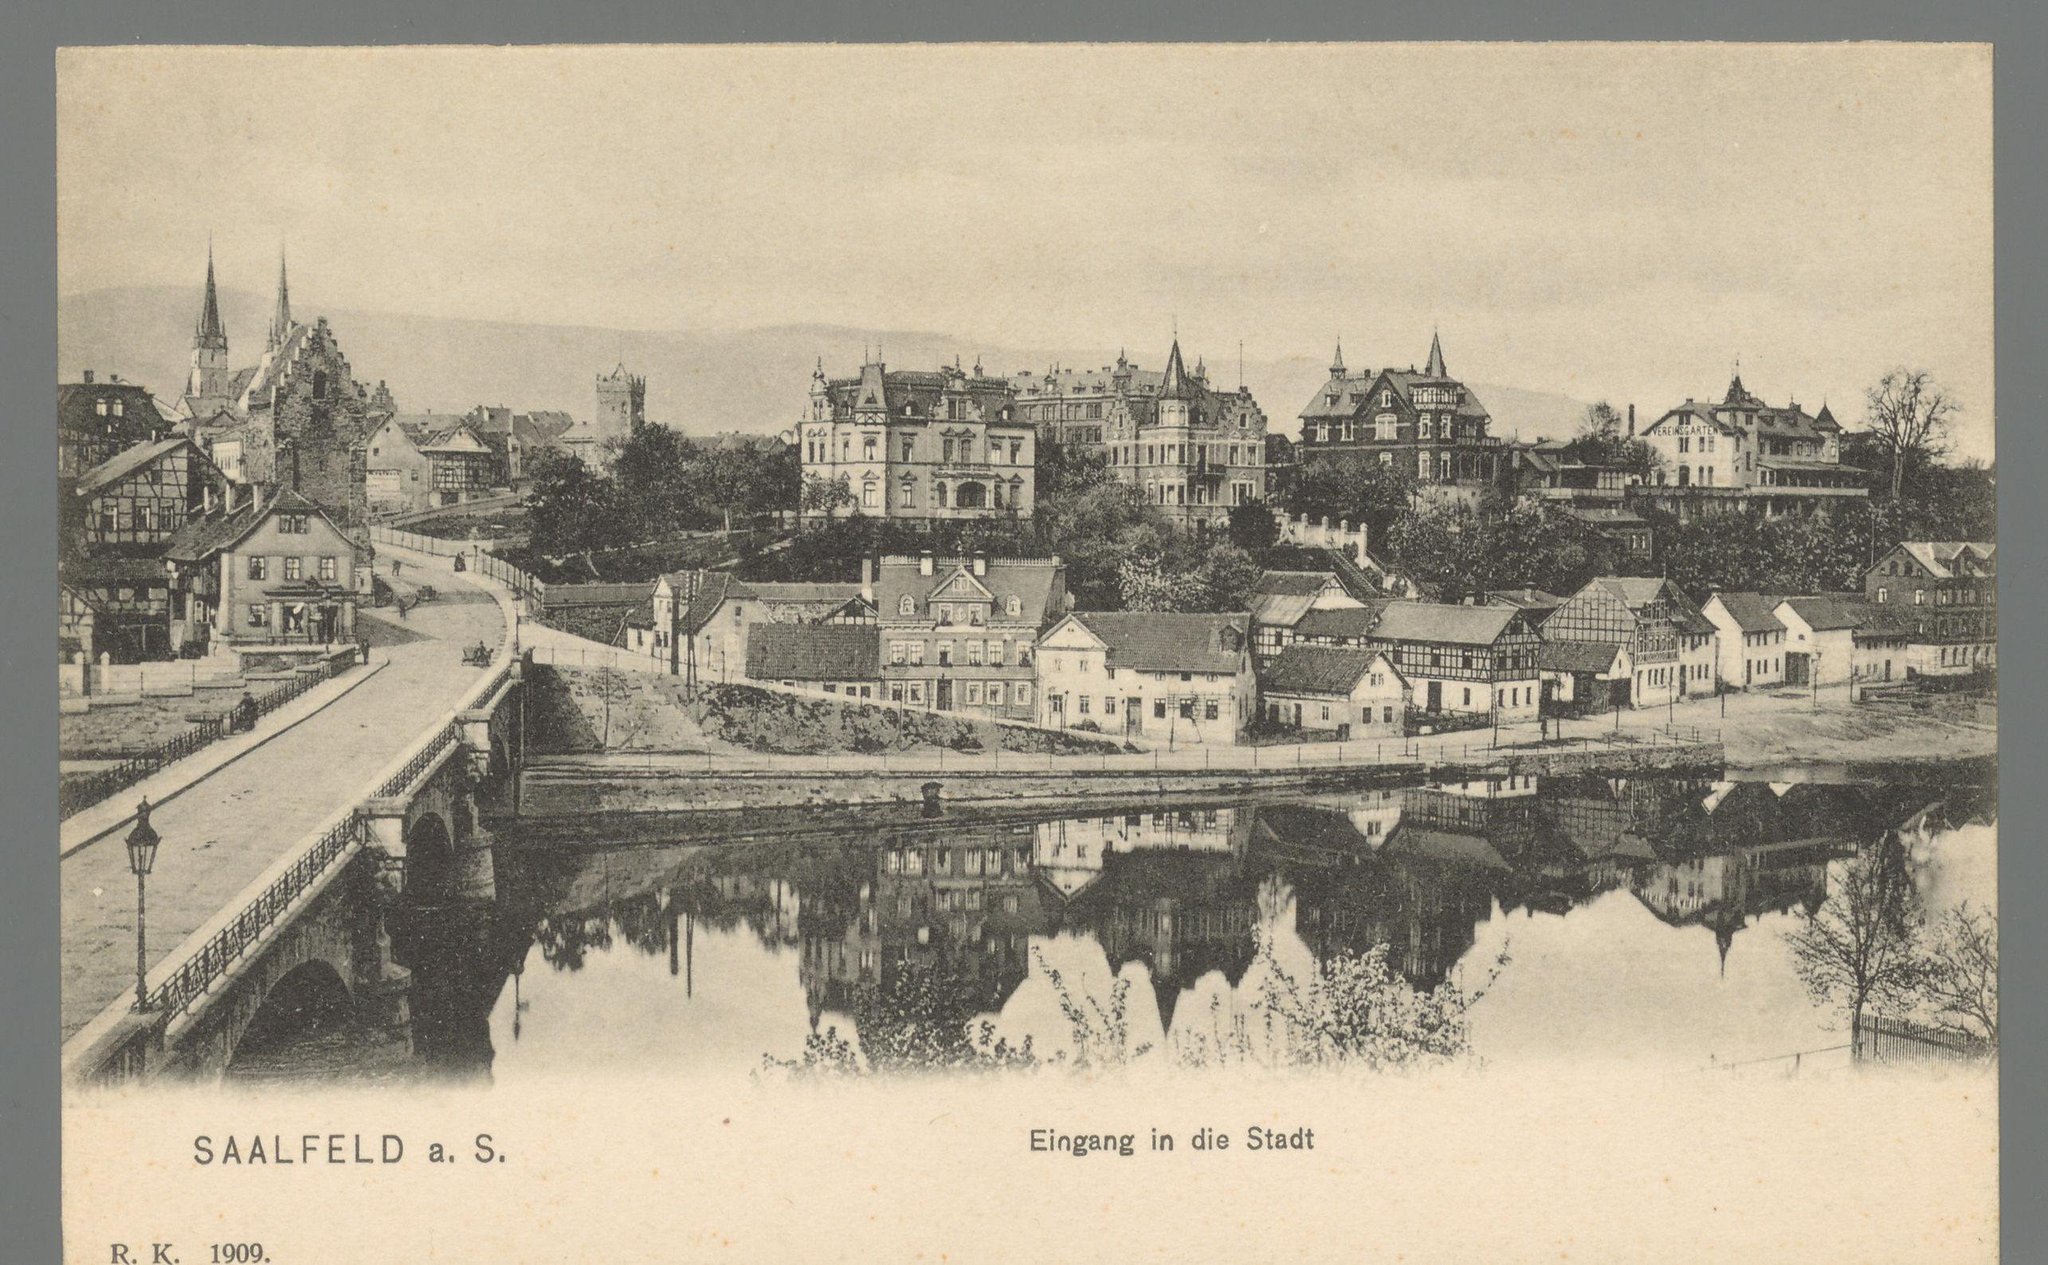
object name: photomechanical print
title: Saalfeld a. S. - Eingang in die Stadt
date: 1909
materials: cardboard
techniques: photograph, writing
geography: saalfeld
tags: city-view, and landscape with man-made constructions, canals, waters (in city), bridge in city across river, canal, etc.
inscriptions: inscription: ‘R. K.’